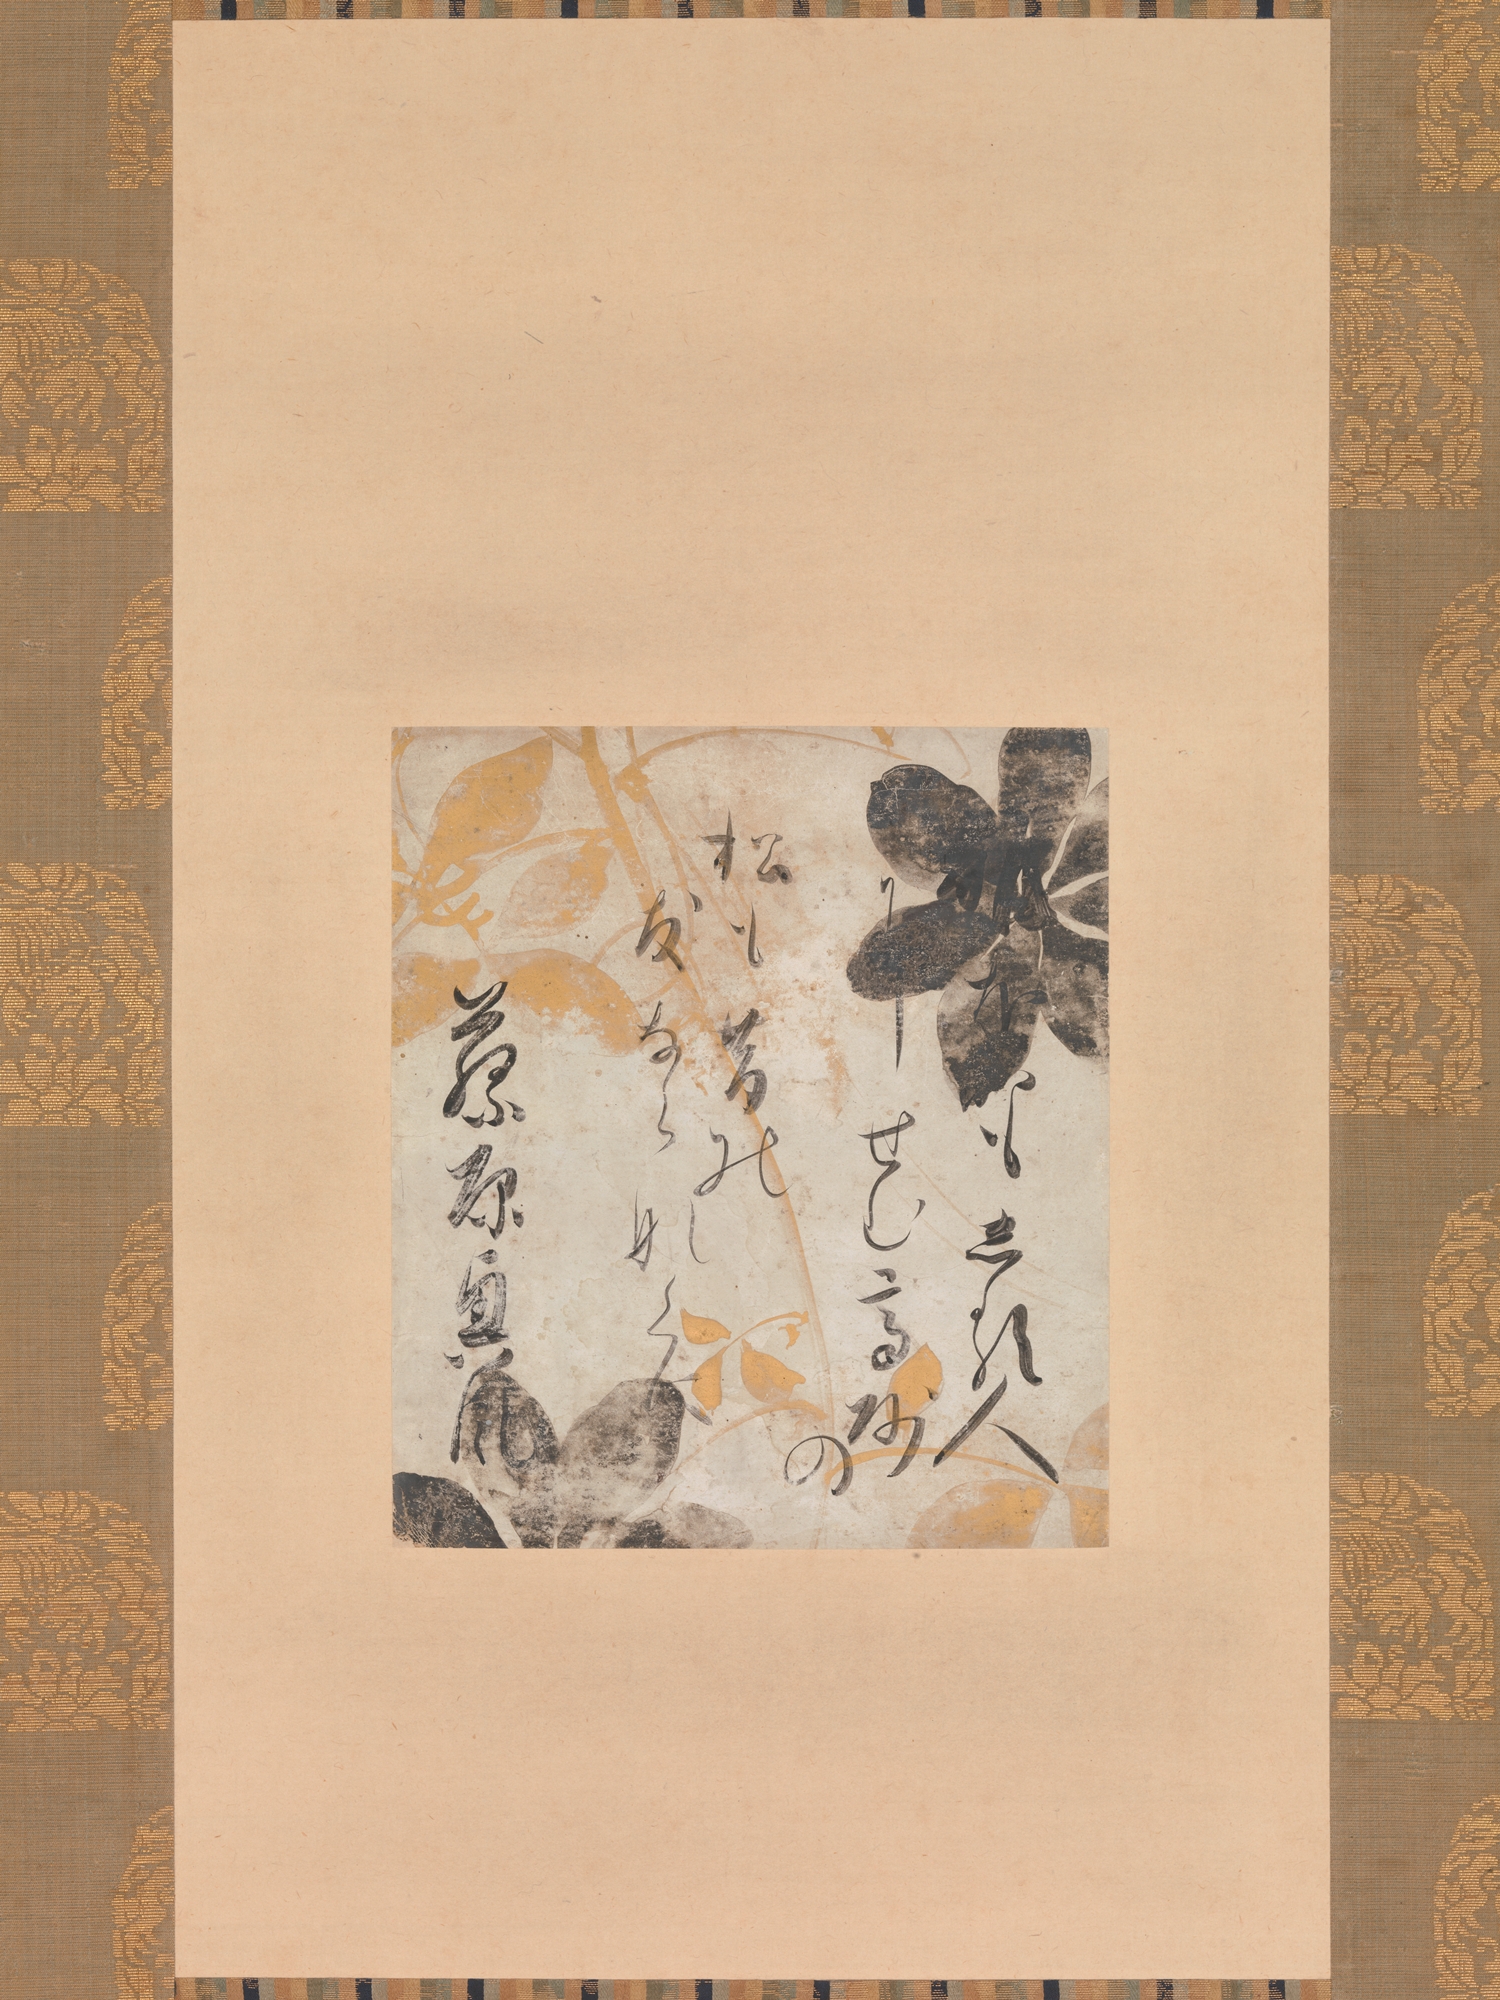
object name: hanging scroll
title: Poem by Fujiwara no Okikaze with Underpainting of Clematis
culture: japanese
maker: shōkadō shōjō 松花堂昭乗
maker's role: artist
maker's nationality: japanese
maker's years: 1584-1639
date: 1601-1633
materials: gold, ink, paper, silver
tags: poetry,flowers